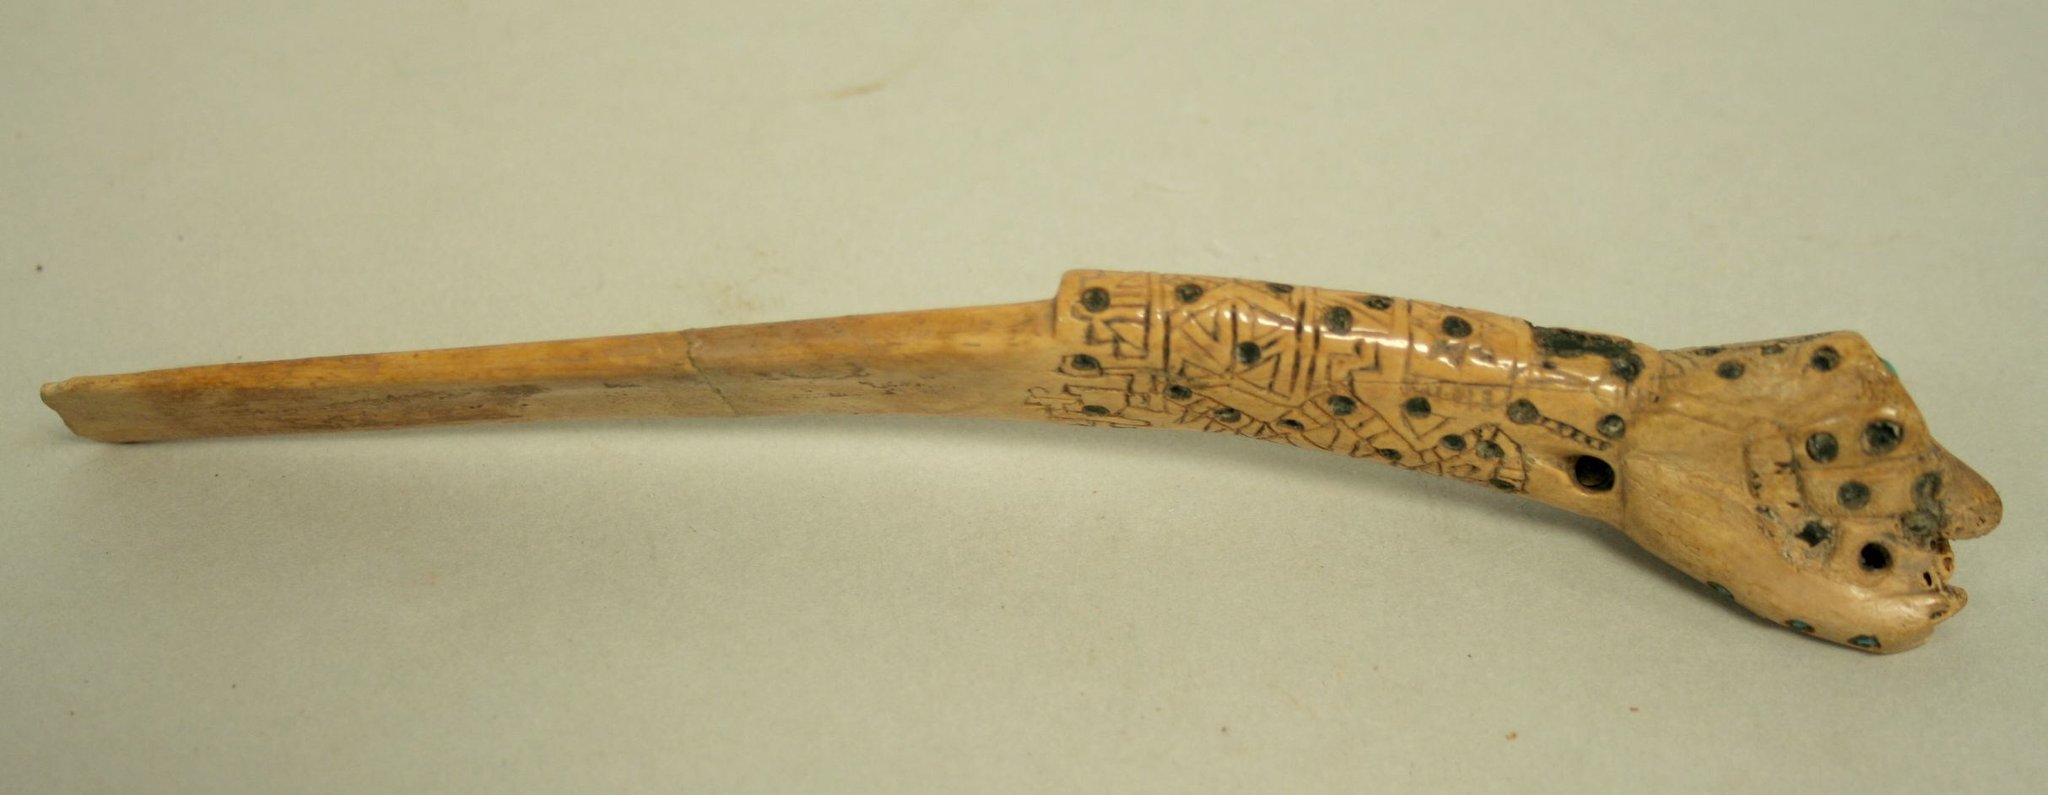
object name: spatula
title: Spatula in the Form of a Hand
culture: moche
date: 201-700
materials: bone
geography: peru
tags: hands